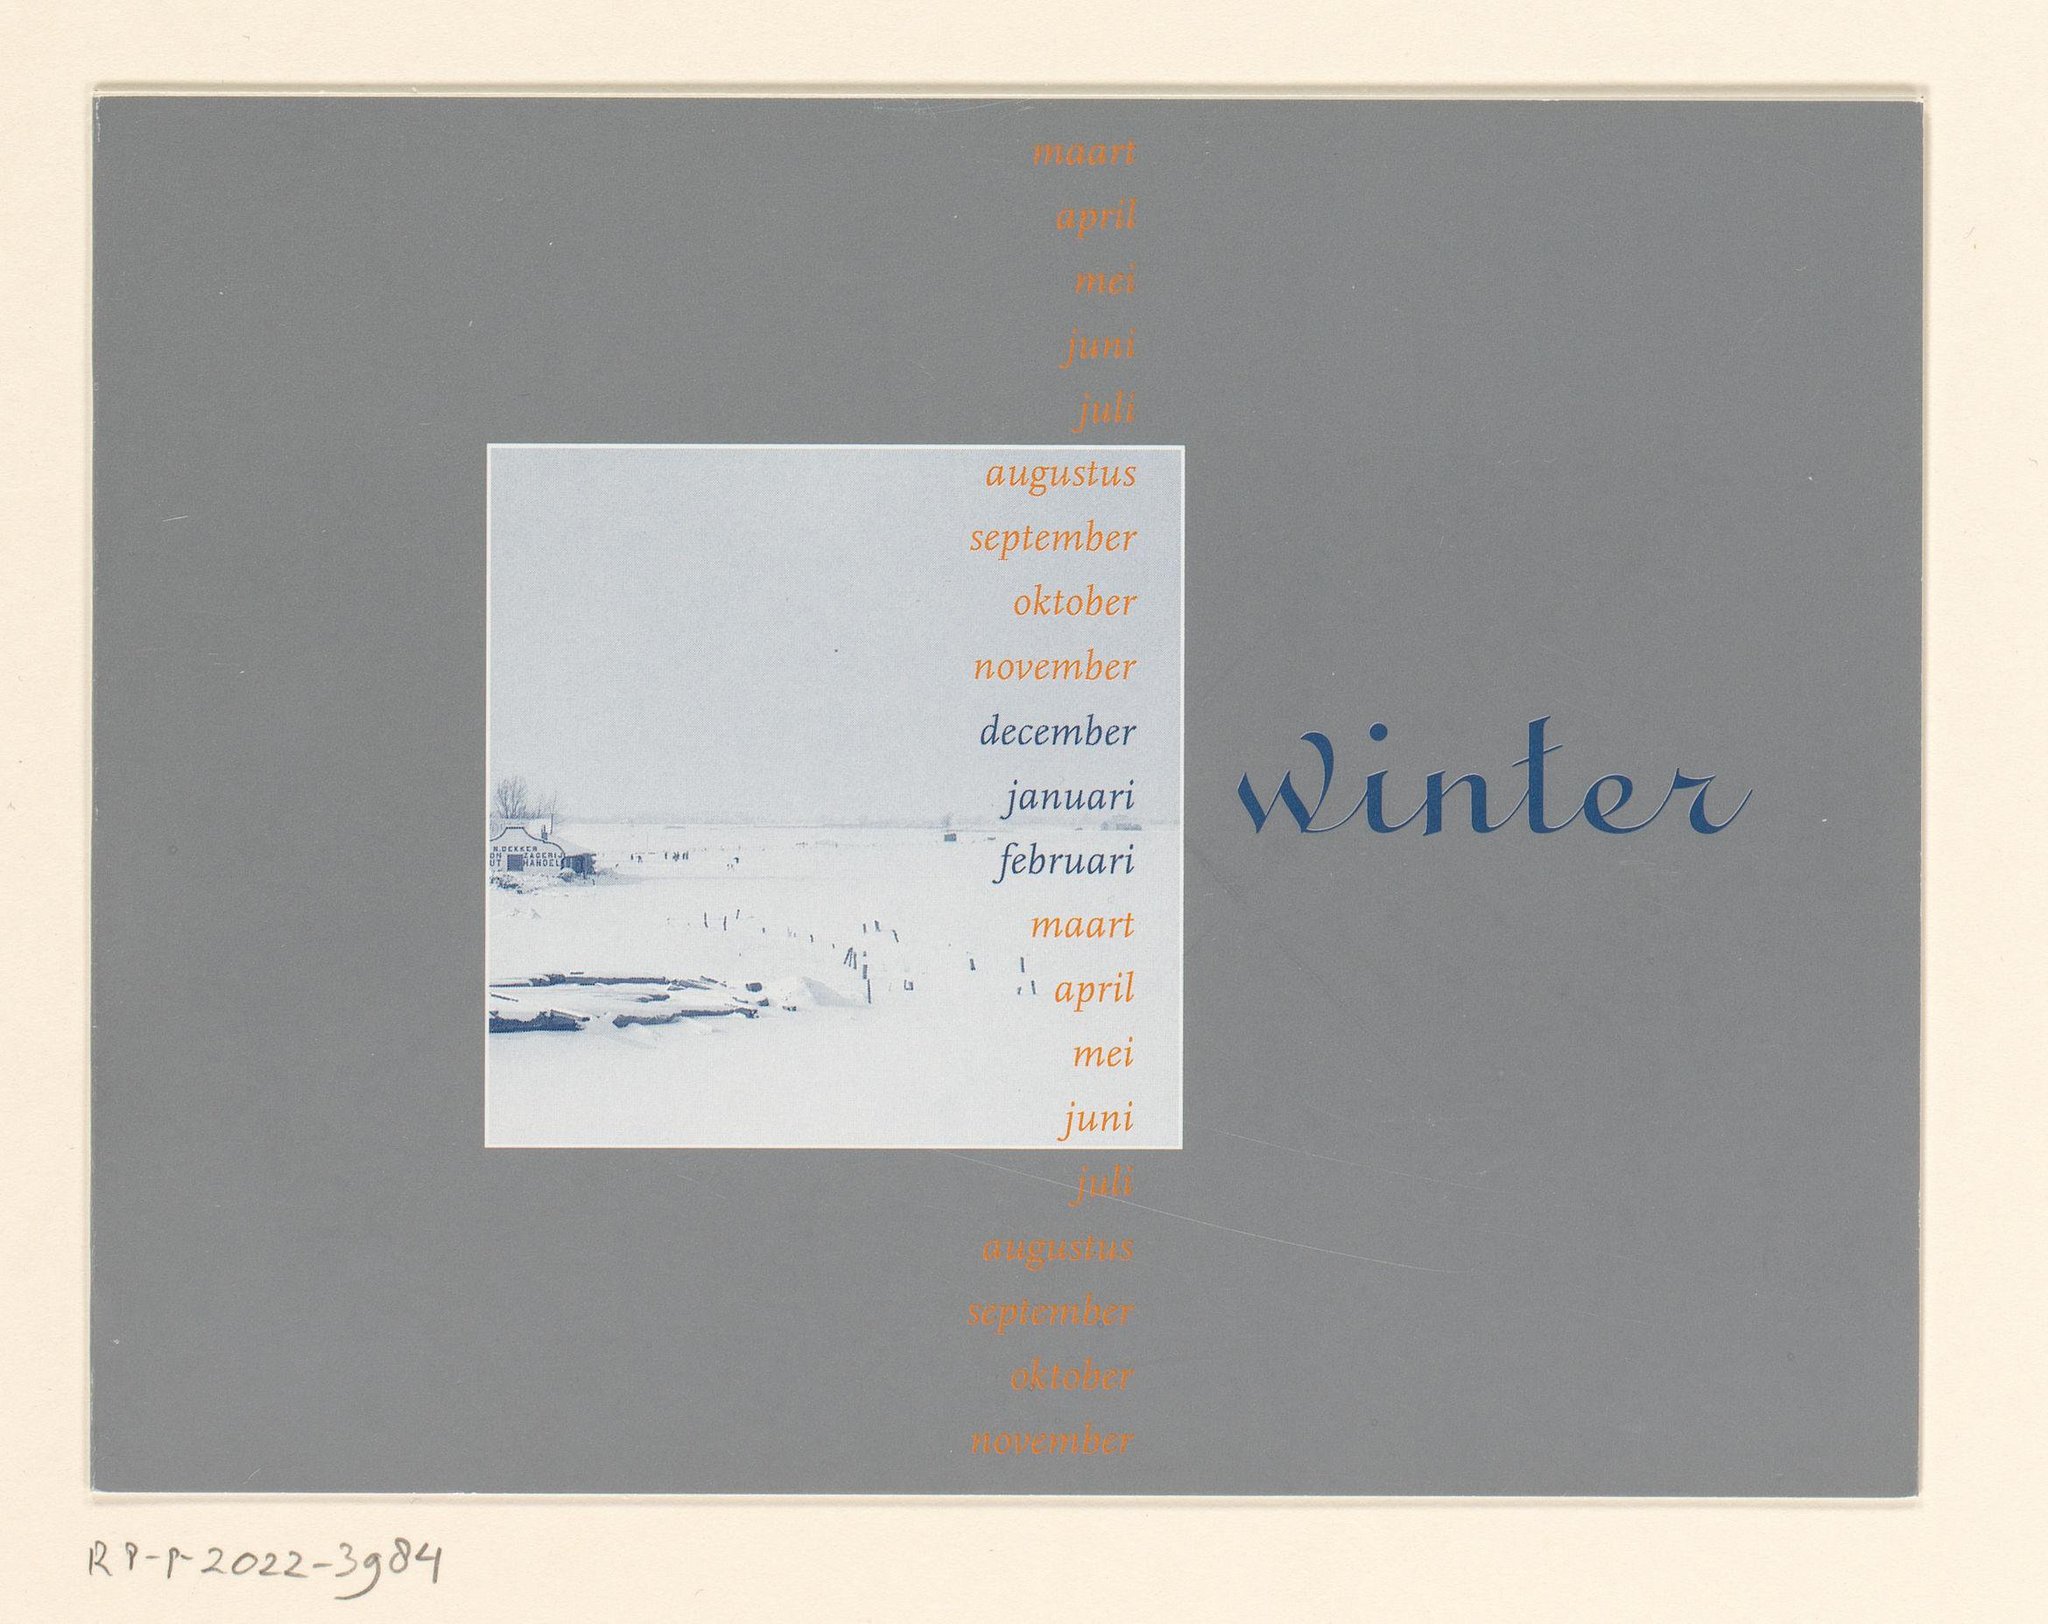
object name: new year card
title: Kerst- en Nieuwjaarskaart voor 2001 van Deloitte & Touche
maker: frits j. rotgans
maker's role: fotograaf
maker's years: 1912-1978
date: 2000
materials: paper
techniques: offset printed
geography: netherlands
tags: christmas card, winter landscape; landscape symbolizing winter (the four seasons of the year), windmill in landscape, january 1 (~ festivities)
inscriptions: collector's mark: Lugt 2228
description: Kerst- en Nieuwjaarskaart voor 2001 van Deloitte & Touche. Wintermaanden, binnenin een foto van een winterlandschap.